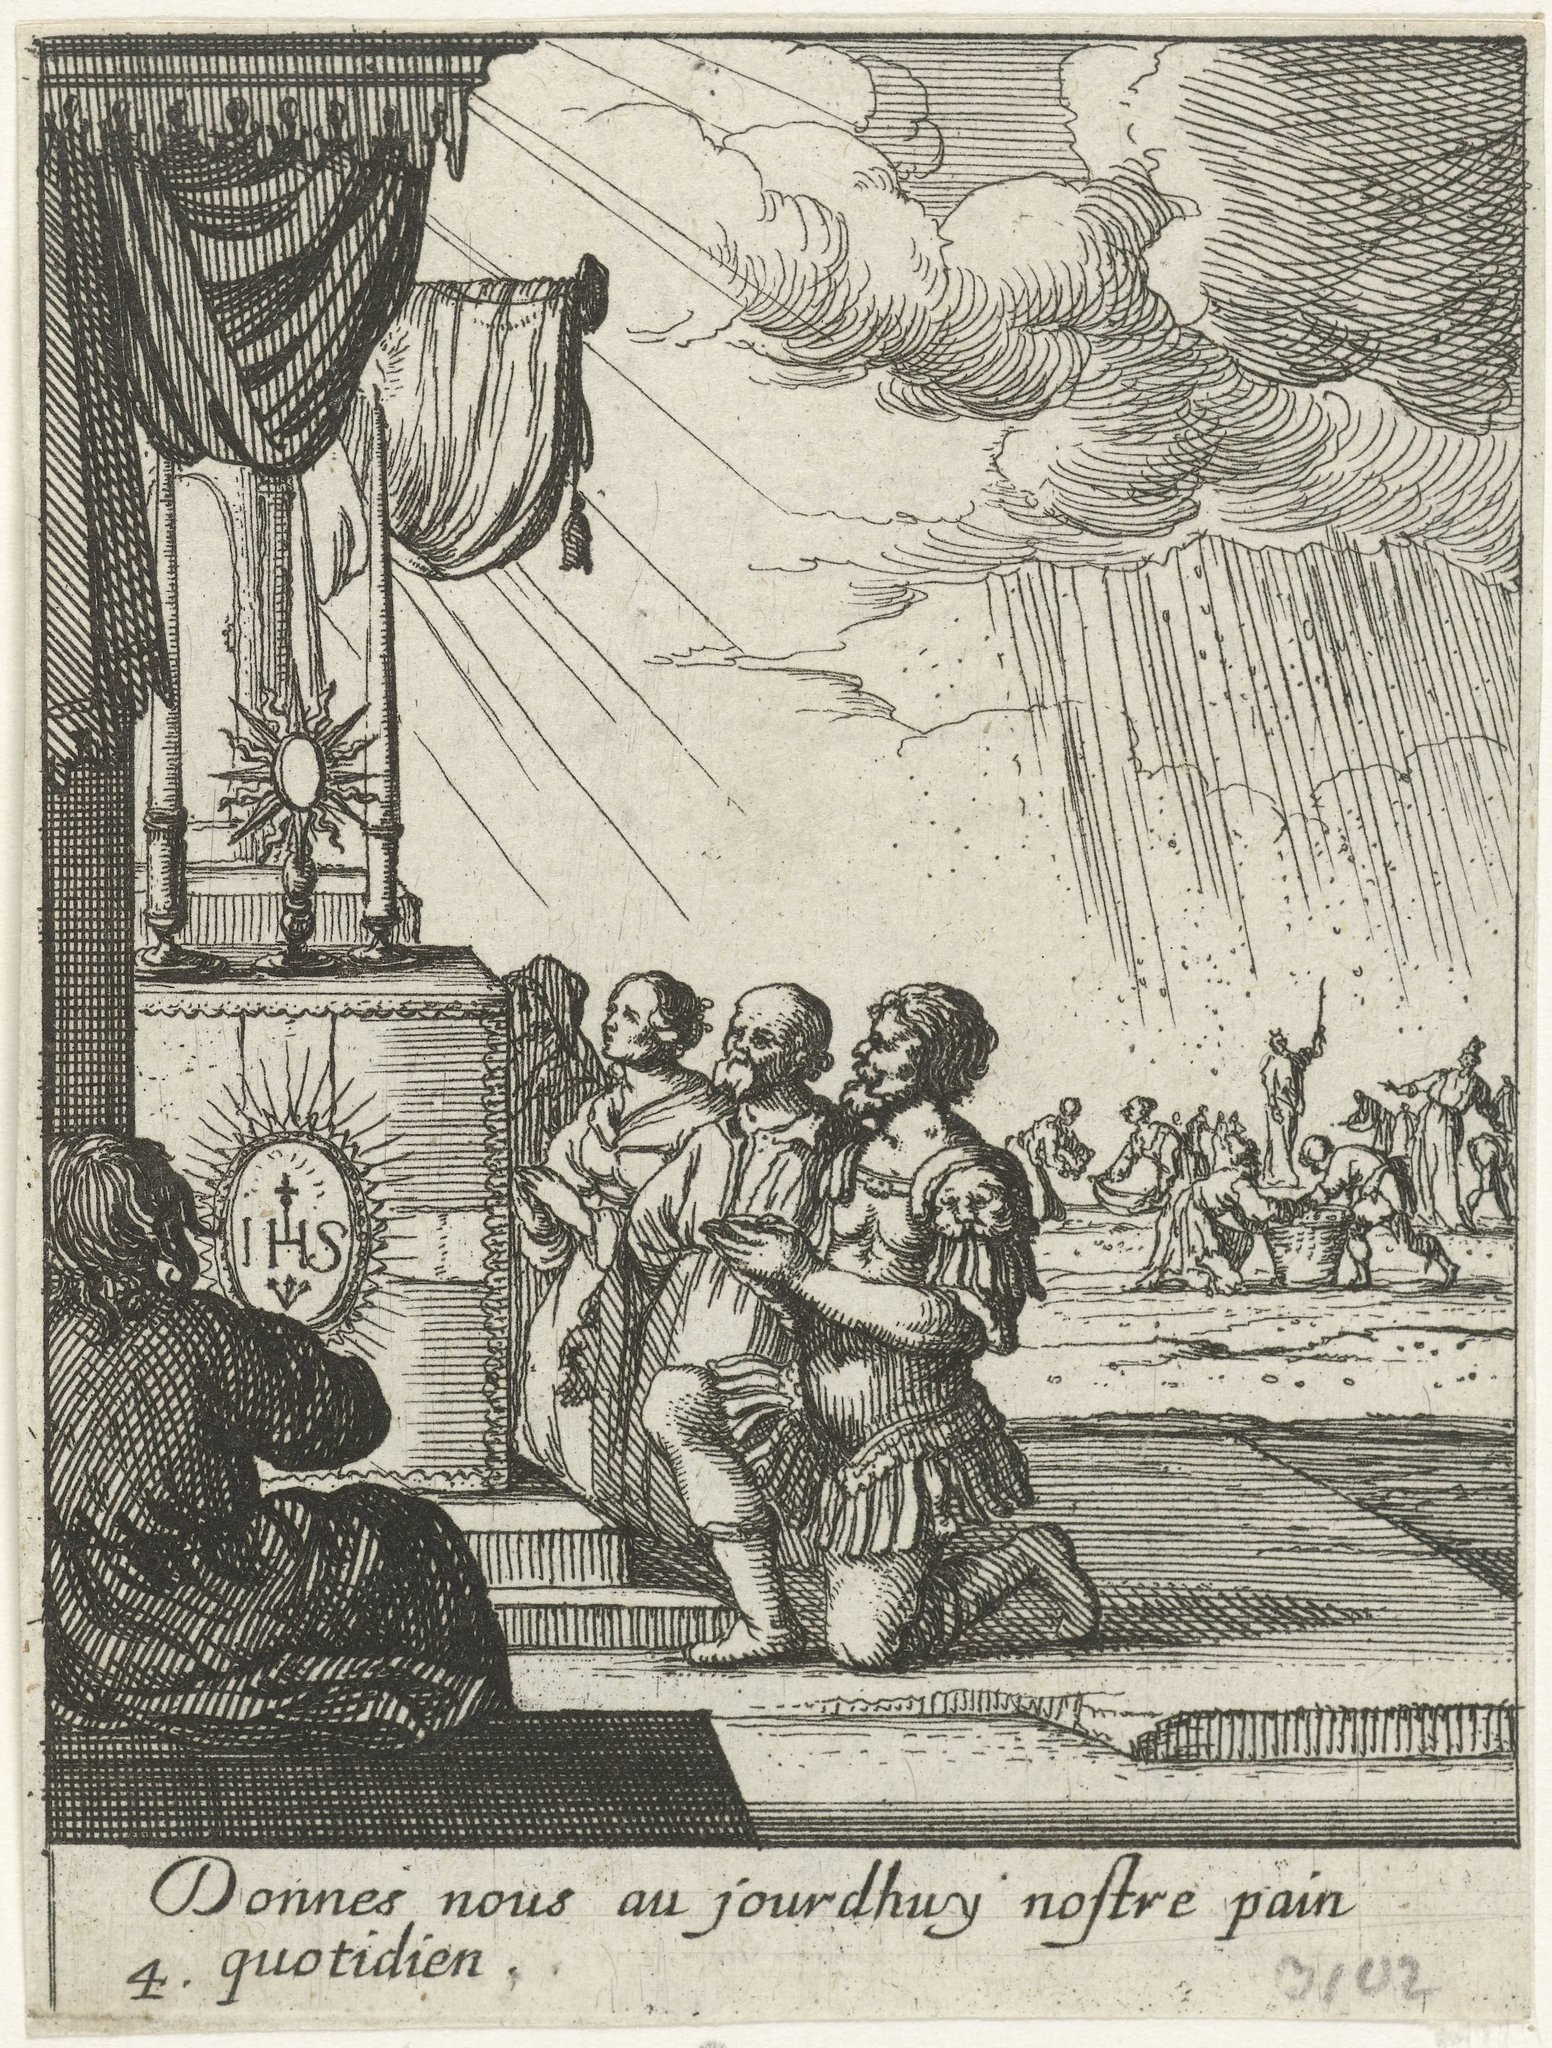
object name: print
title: Onze Vader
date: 1648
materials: paper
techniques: etching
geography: paris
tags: 'give us this day our daily bread' ~ the lord's prayer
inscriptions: collector's mark: Lugt 2228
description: Drie personen knielen met gevouwen handen voor een altaar. Op de achtergrond verzamelt een menigte uit de hemel vallend manna. Het Franse onderschrift is een deel uit het gebed het Onze Vader.